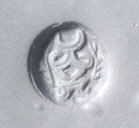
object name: stamp seal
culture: sasanian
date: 201-700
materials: stone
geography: iran